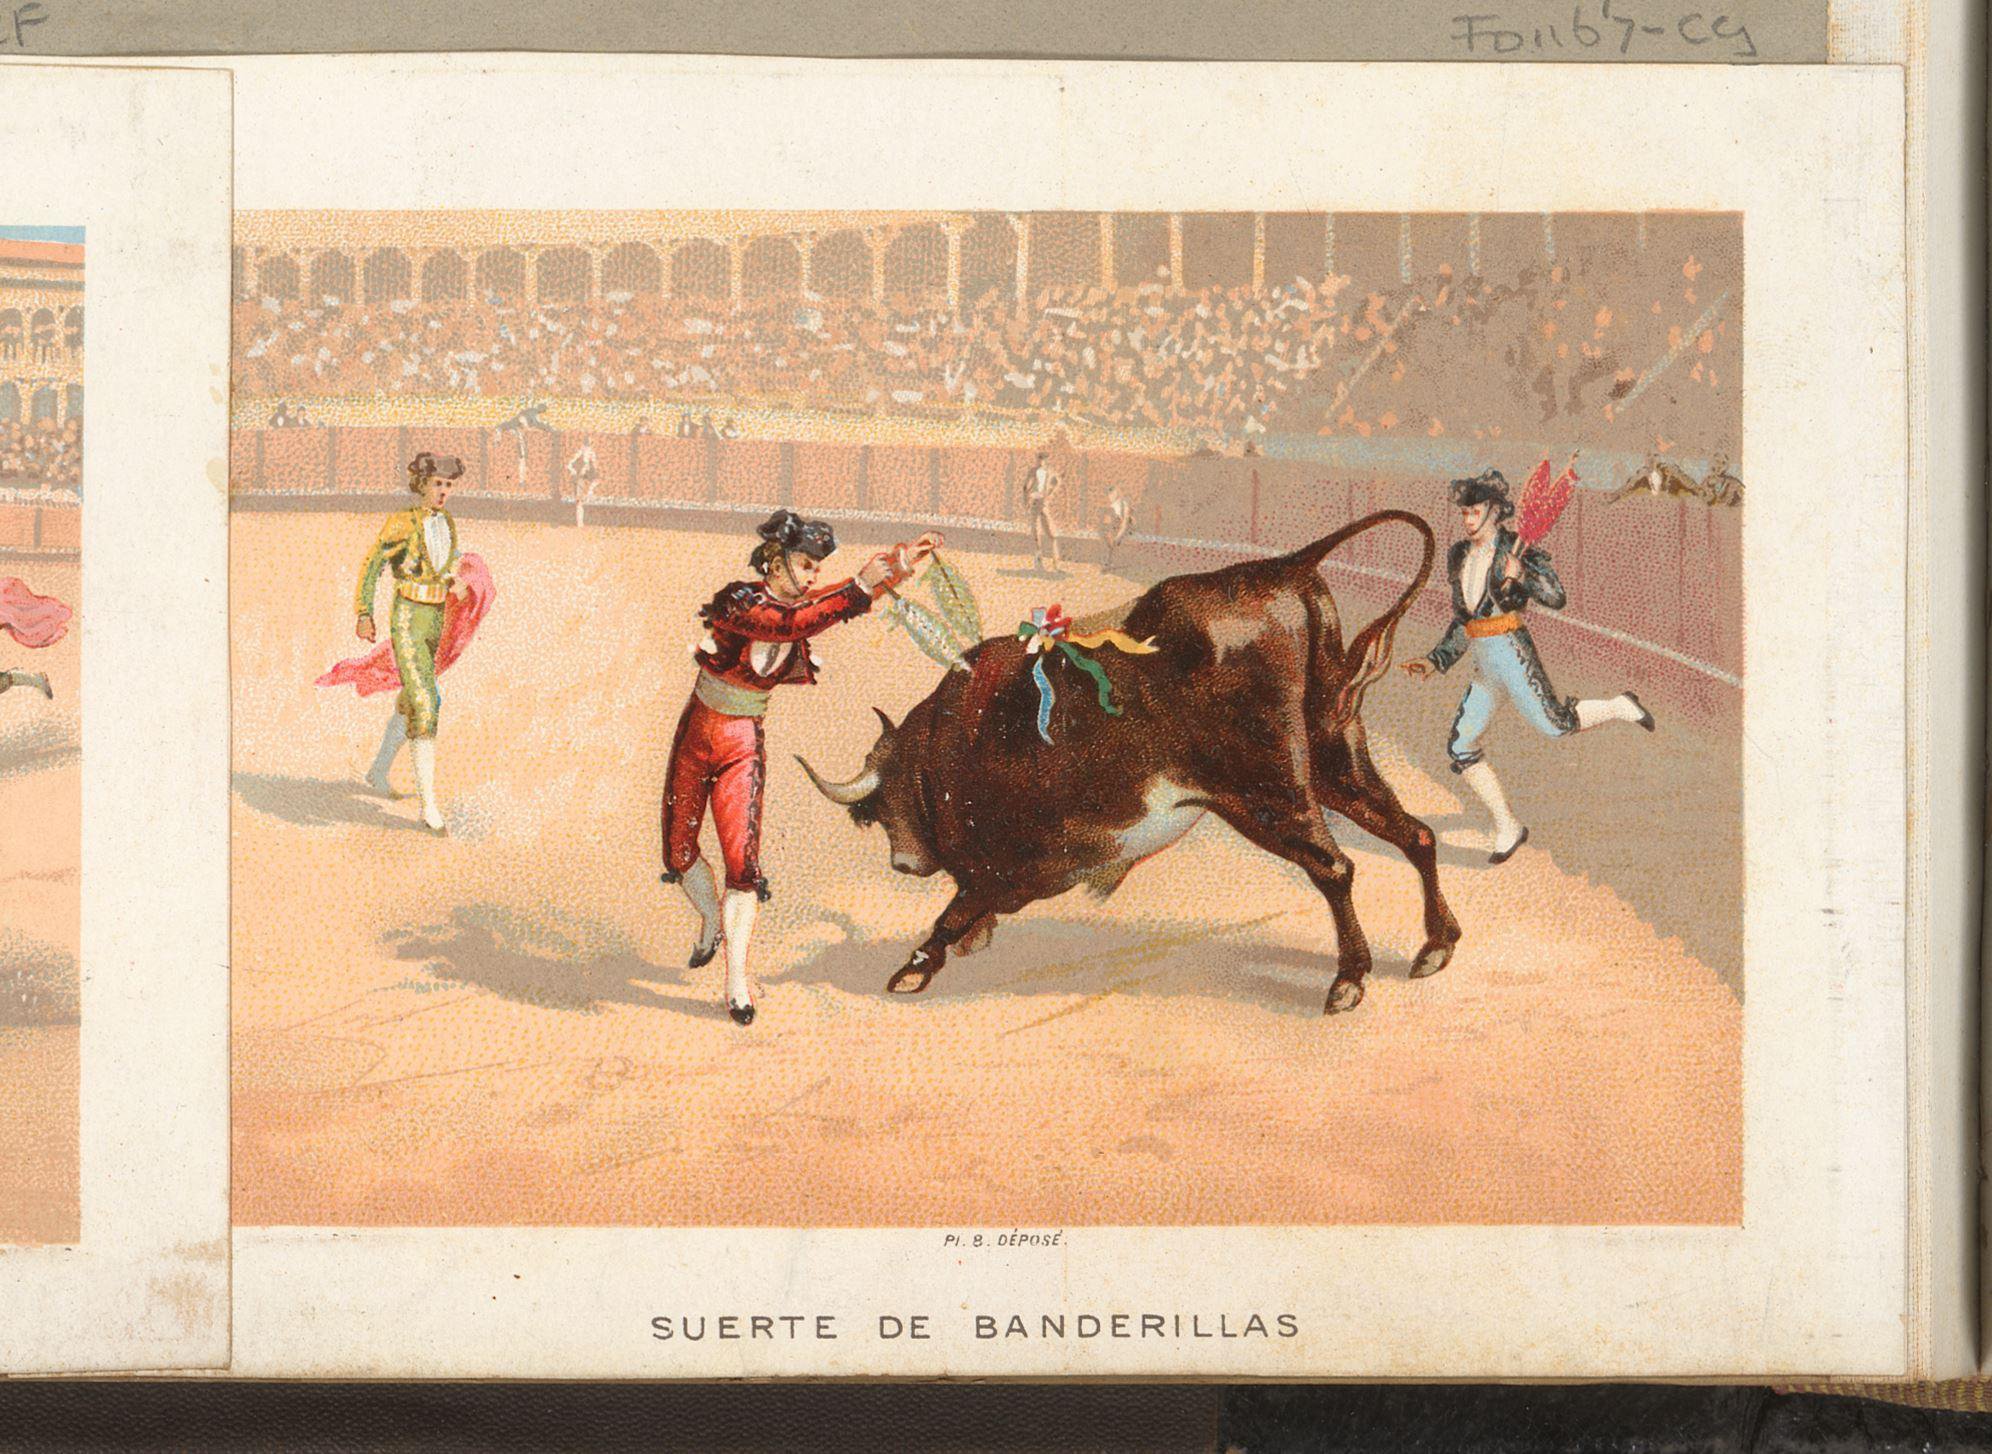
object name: album leaf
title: Suerte de banderillas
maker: Anonymous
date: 1880-1910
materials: paper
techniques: chromolithography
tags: bullfight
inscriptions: inscription: ‘Pl. 9. Déposé’